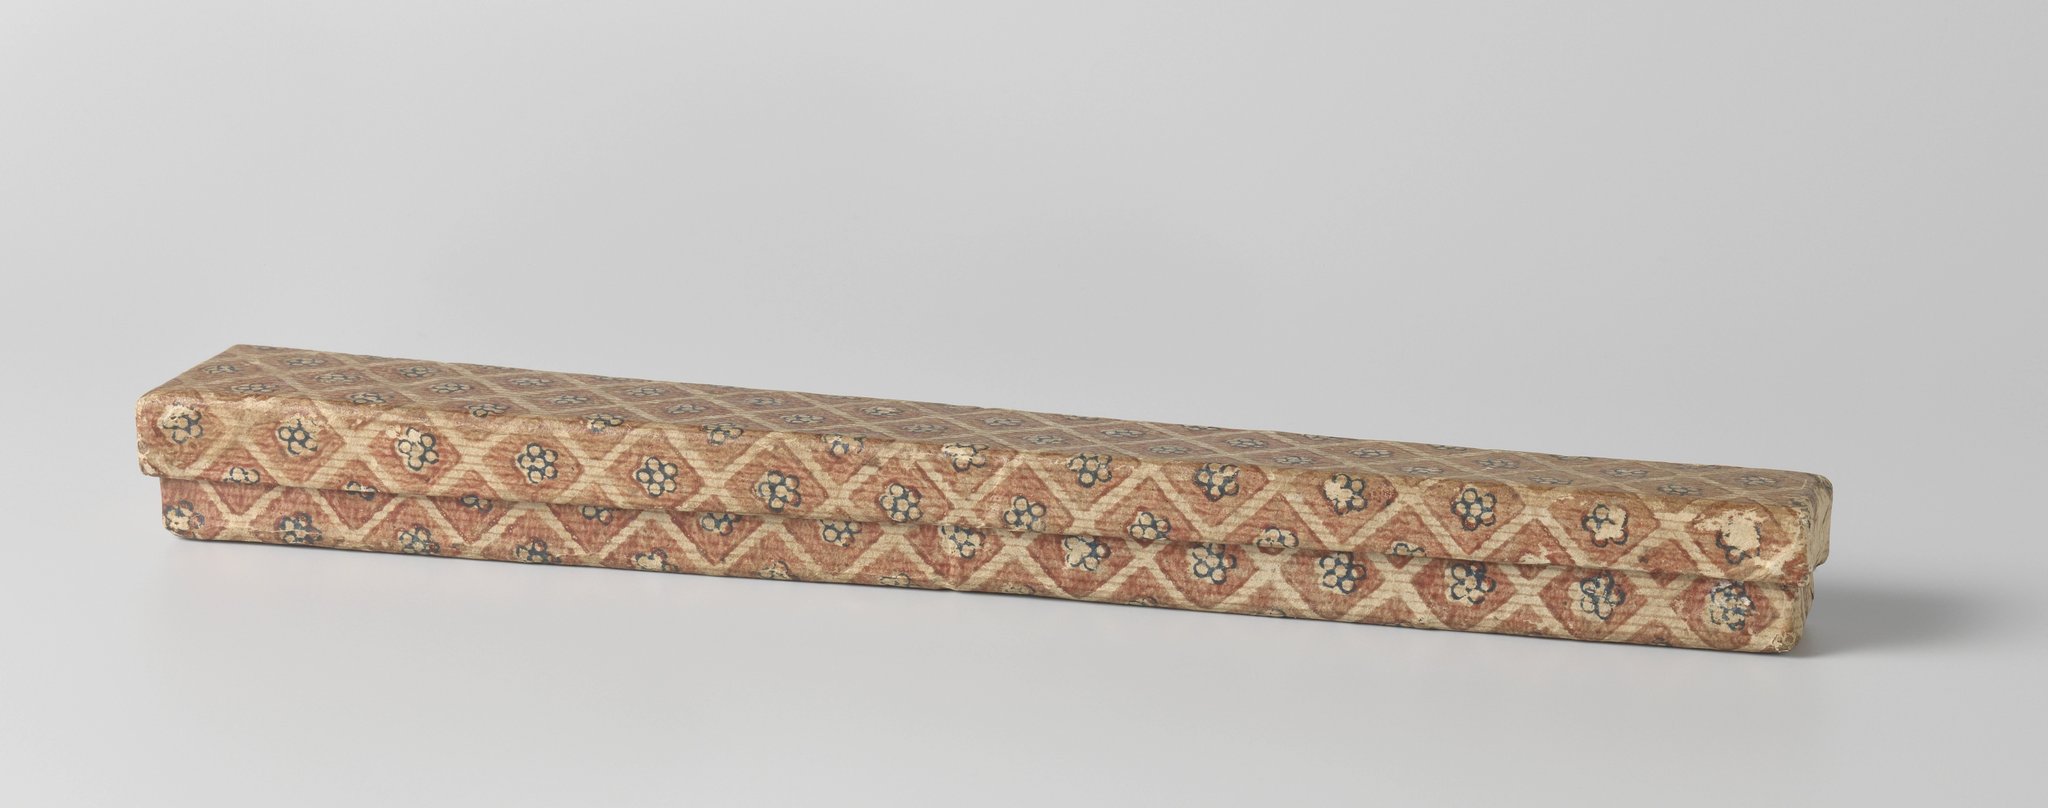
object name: packing material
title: Waaierdoos met deksel, van dik papier, aan buitenzijde beplakt met sitspapier met ruitmotief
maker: Anonymous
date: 1795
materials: paint, paper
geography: netherlands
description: Waaierdoos met deksel, van dik papier, aan buitenzijde beplakt met sitspapier met ruitmotief. Binnenzijde onbeplakt.